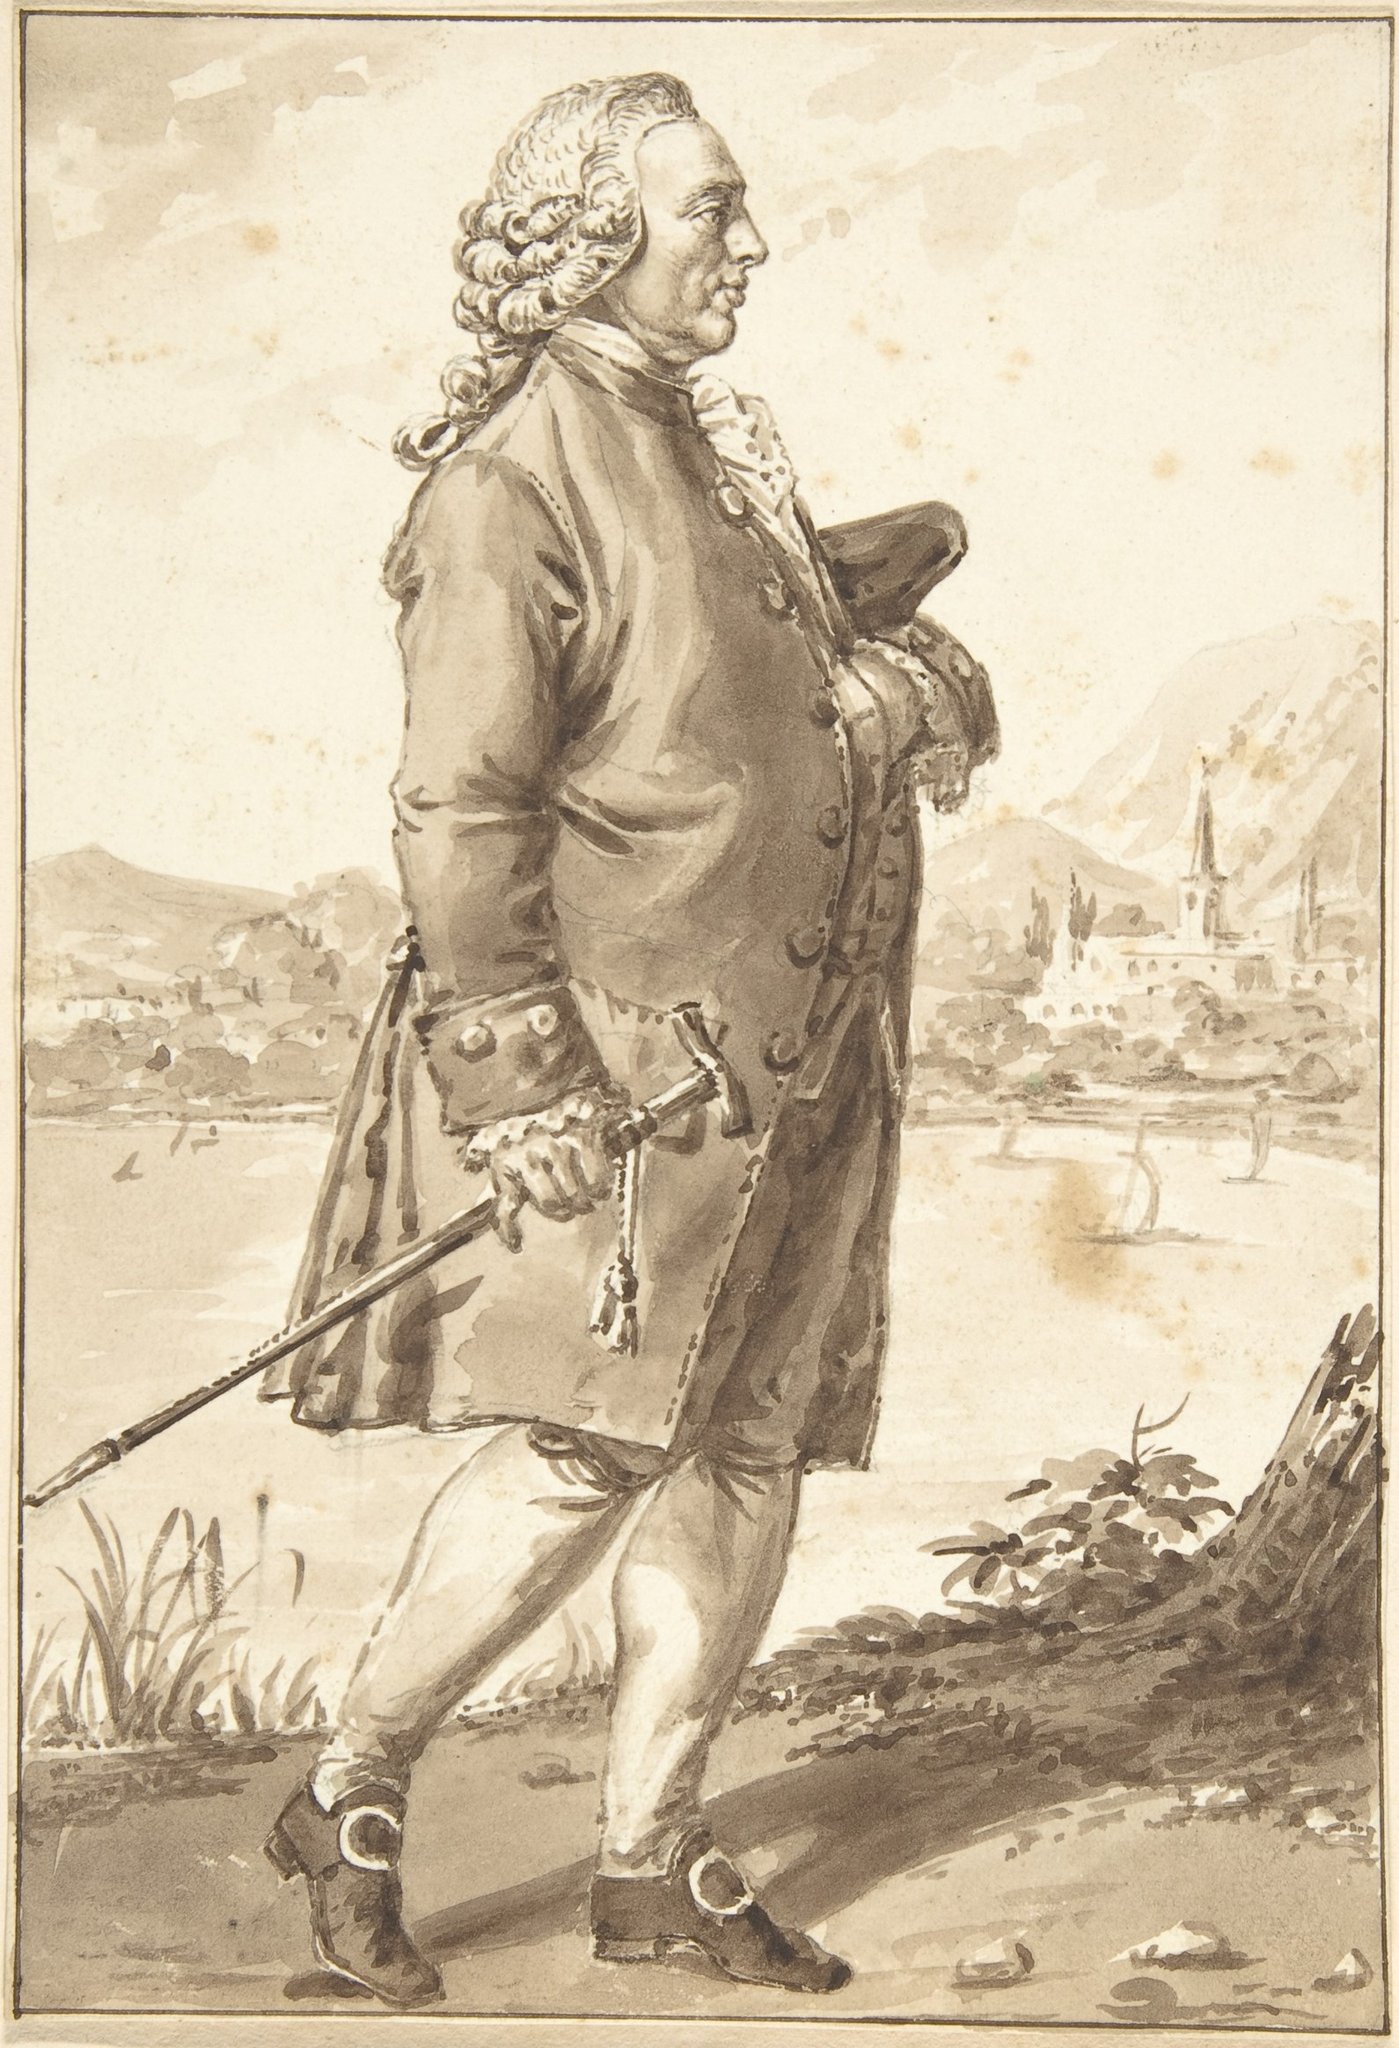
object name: drawing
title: Portrait of Charles Bonnet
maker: jean-baptiste-françois bosio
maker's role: artist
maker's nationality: french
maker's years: 1764-1827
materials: graphite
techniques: brush, wash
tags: men,portraits